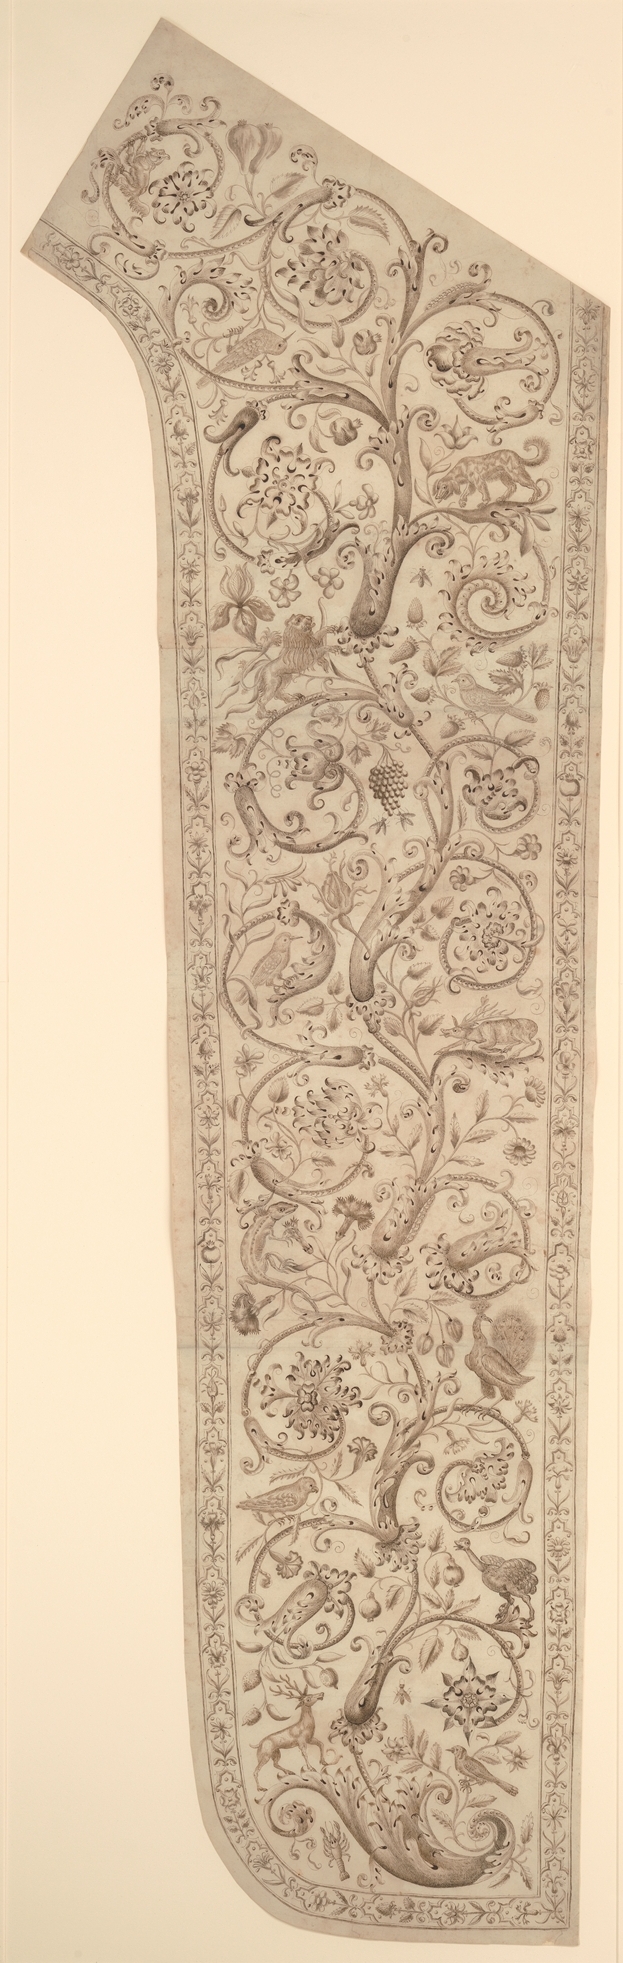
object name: drawing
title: Cartoon for embroidery of a panel of a chasuble, decorated with floral, bud and animal designs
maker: anonymous, italian, 17th century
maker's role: artist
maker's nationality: italian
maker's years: 1600-1700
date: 1608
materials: ink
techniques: pen